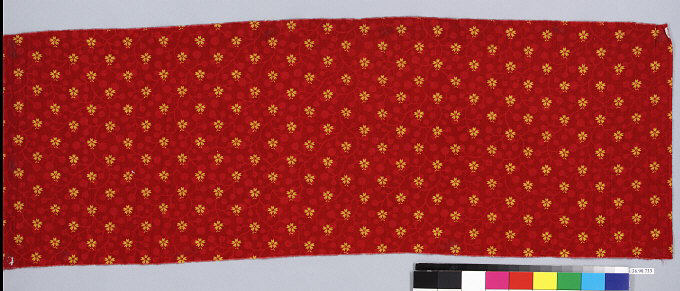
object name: piece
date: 1801-1900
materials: cotton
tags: flowers